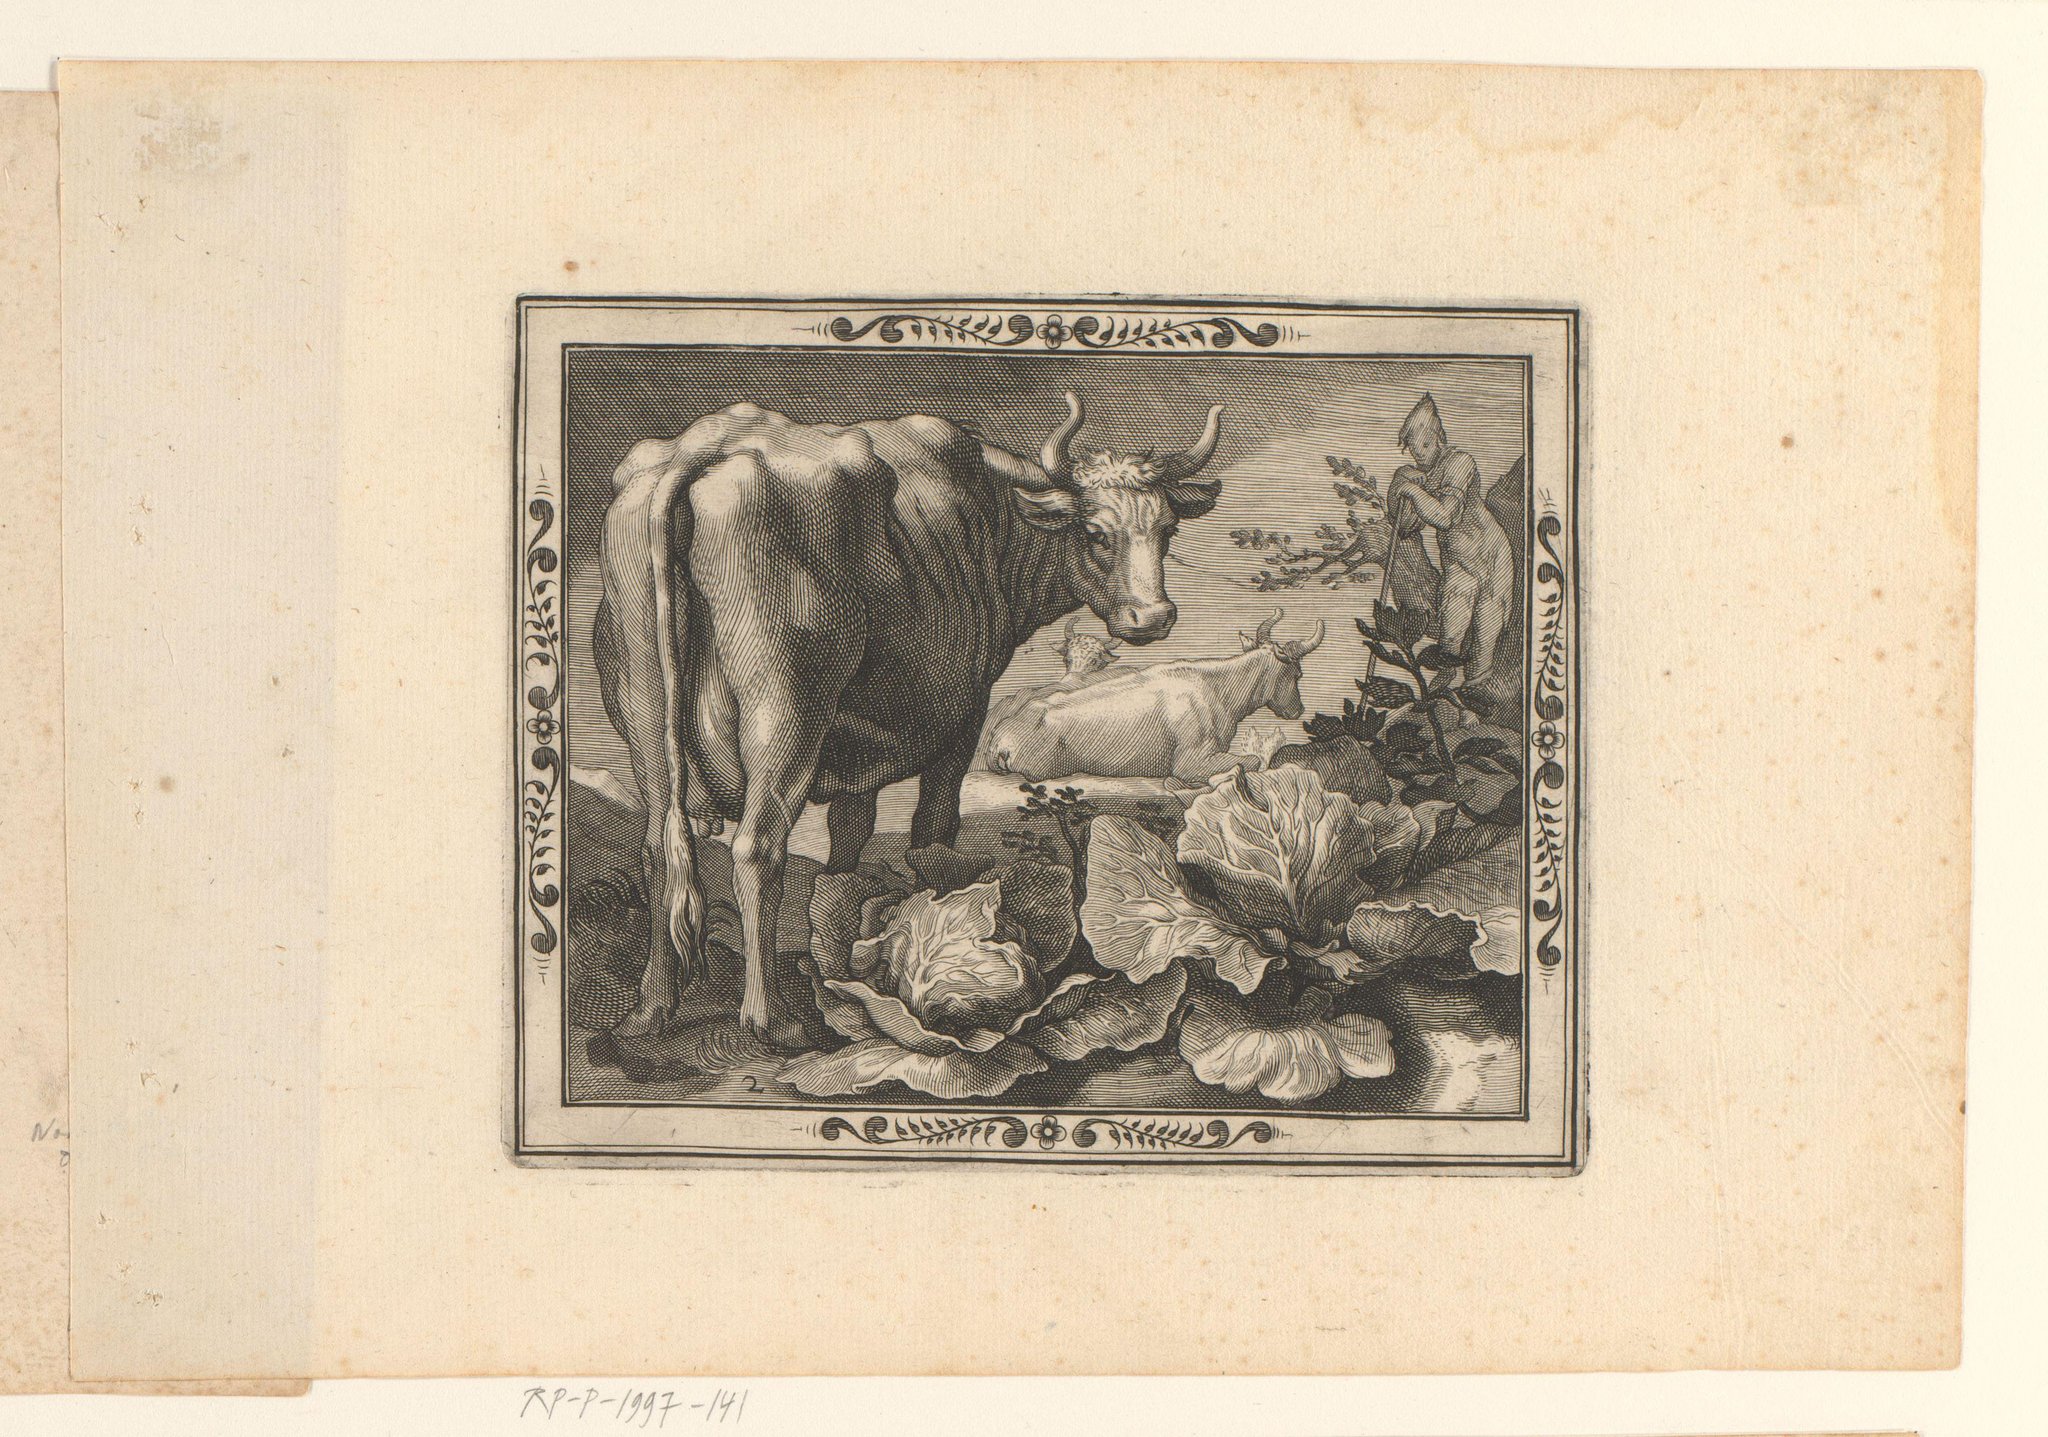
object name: print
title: Diervoorstellingen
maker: jean leclerc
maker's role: print maker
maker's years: 1587-1633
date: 1597-1633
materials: paper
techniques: engraving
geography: france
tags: cow, cattle driving, cattle driver, plants and herbs: cabbage